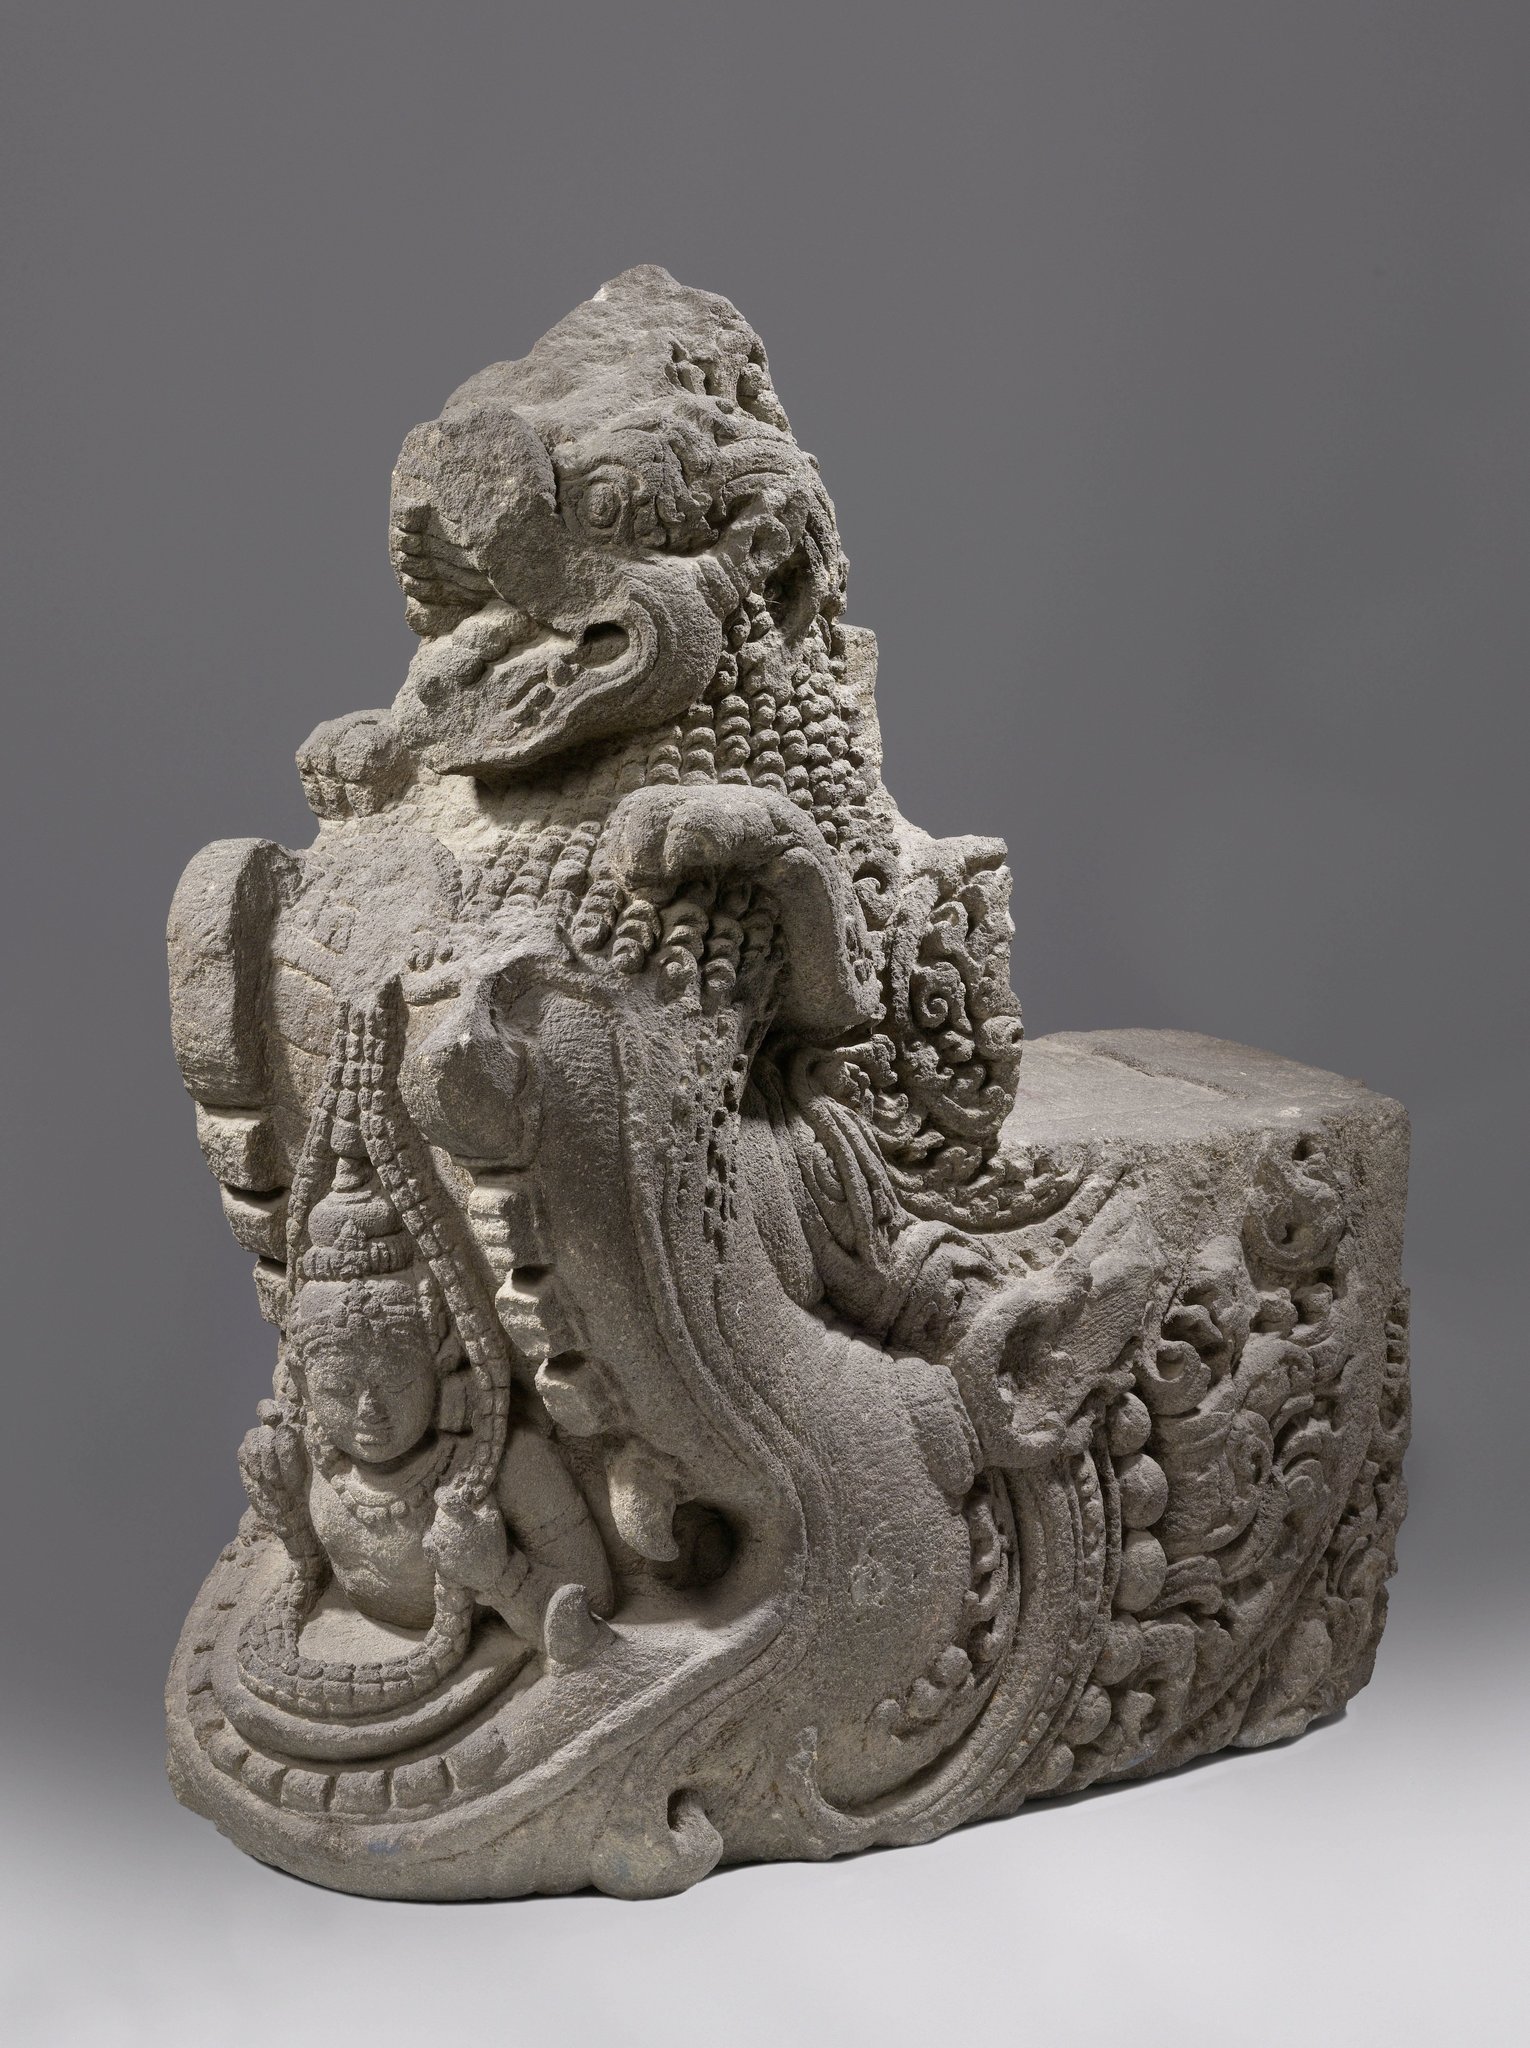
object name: sculpture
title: Makara with a Trunk in the Form of a Lion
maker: Anonymous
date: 800-900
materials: stone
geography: candi bubrah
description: This mythical beast, together with a second, similar figure, originally flanked the main entrance to Candi Bubrah, the shrine to the south of the Buddhist complex of Candi Sewu. The trunk of this makara gradually transforms into a lion-like monster, while a man emerges from its mouth.